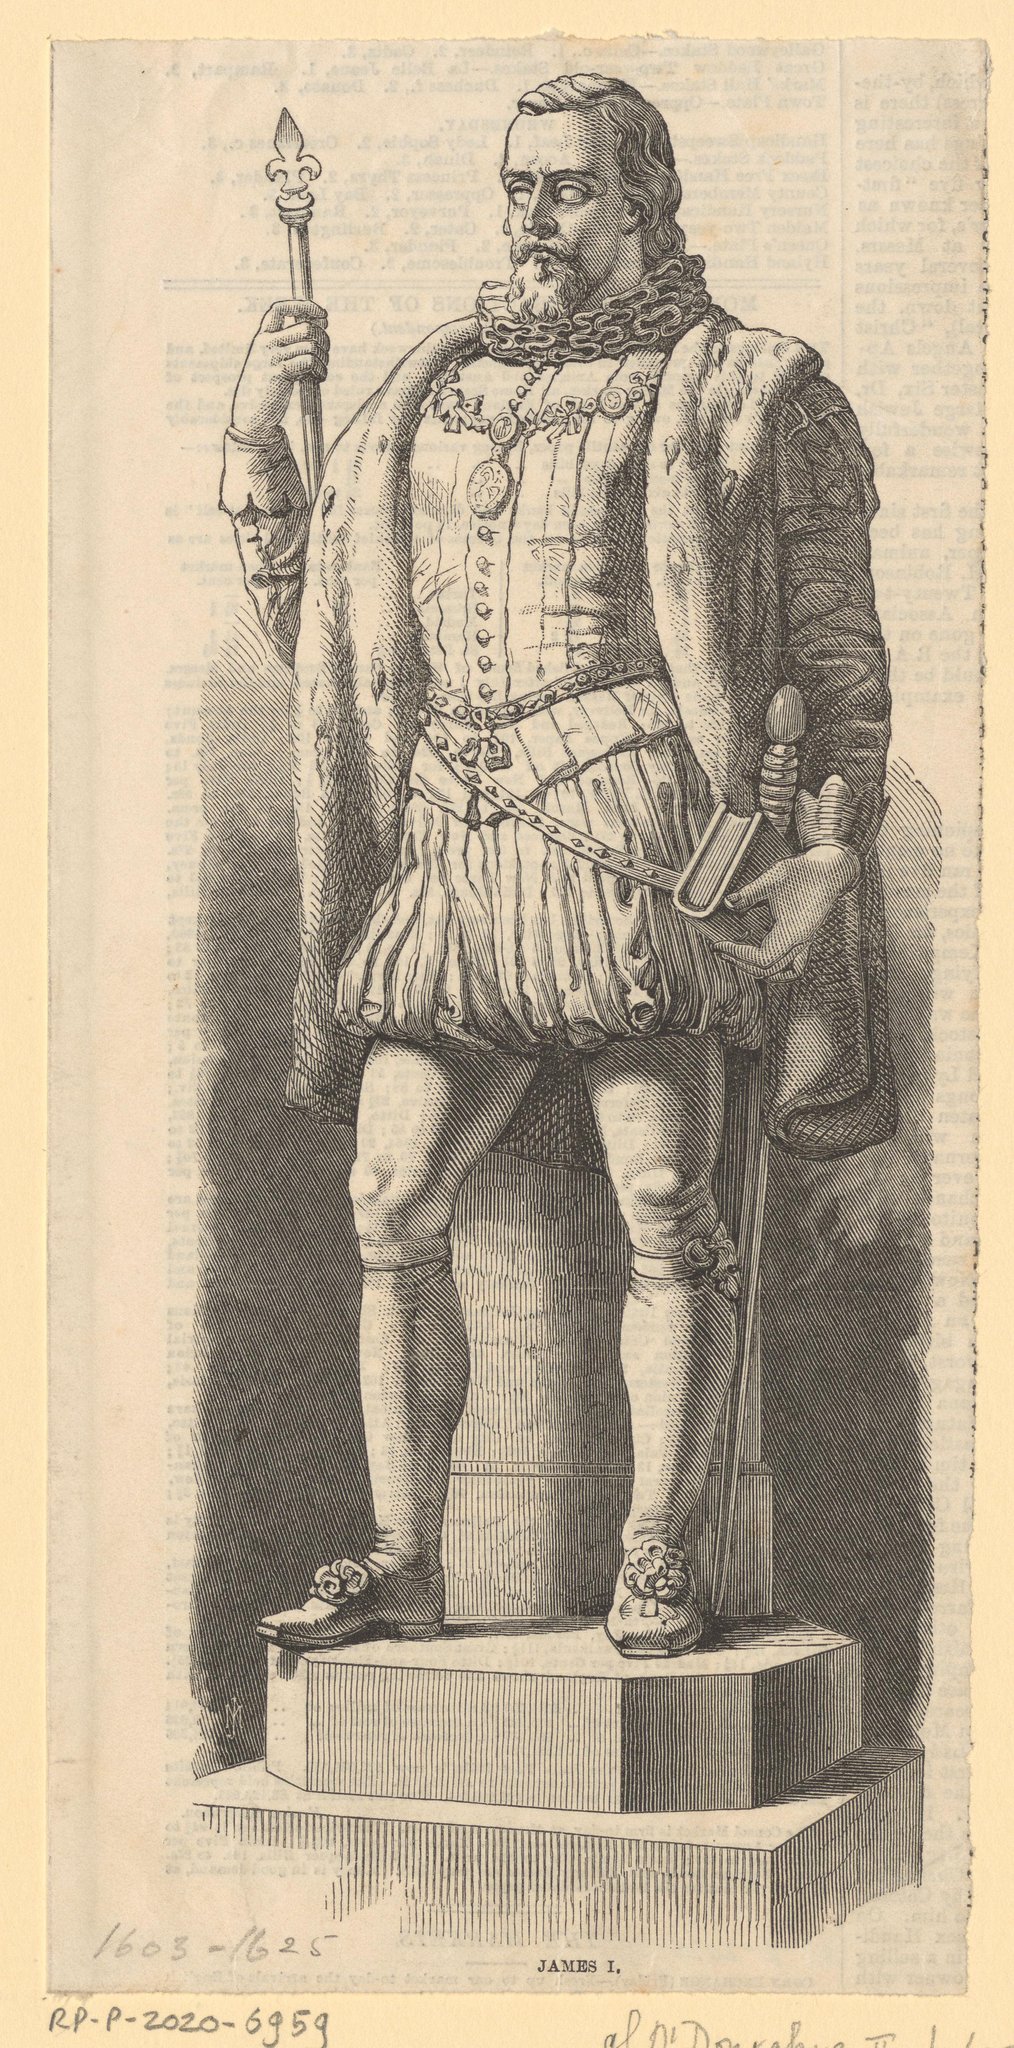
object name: print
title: Portret van Jacobus I, koning van Engeland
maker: Anonymous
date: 1867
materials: paper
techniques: letterpress printing, engraving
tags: jacobus i (koning van engeland), standing figure, sceptre, staff (symbol of sovereignty), historical persons, book, king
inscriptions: monogram: ‘JM’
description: Prent uit: The Illustrated London News 50 (1867), nr. 1433, 29 juni 1867.